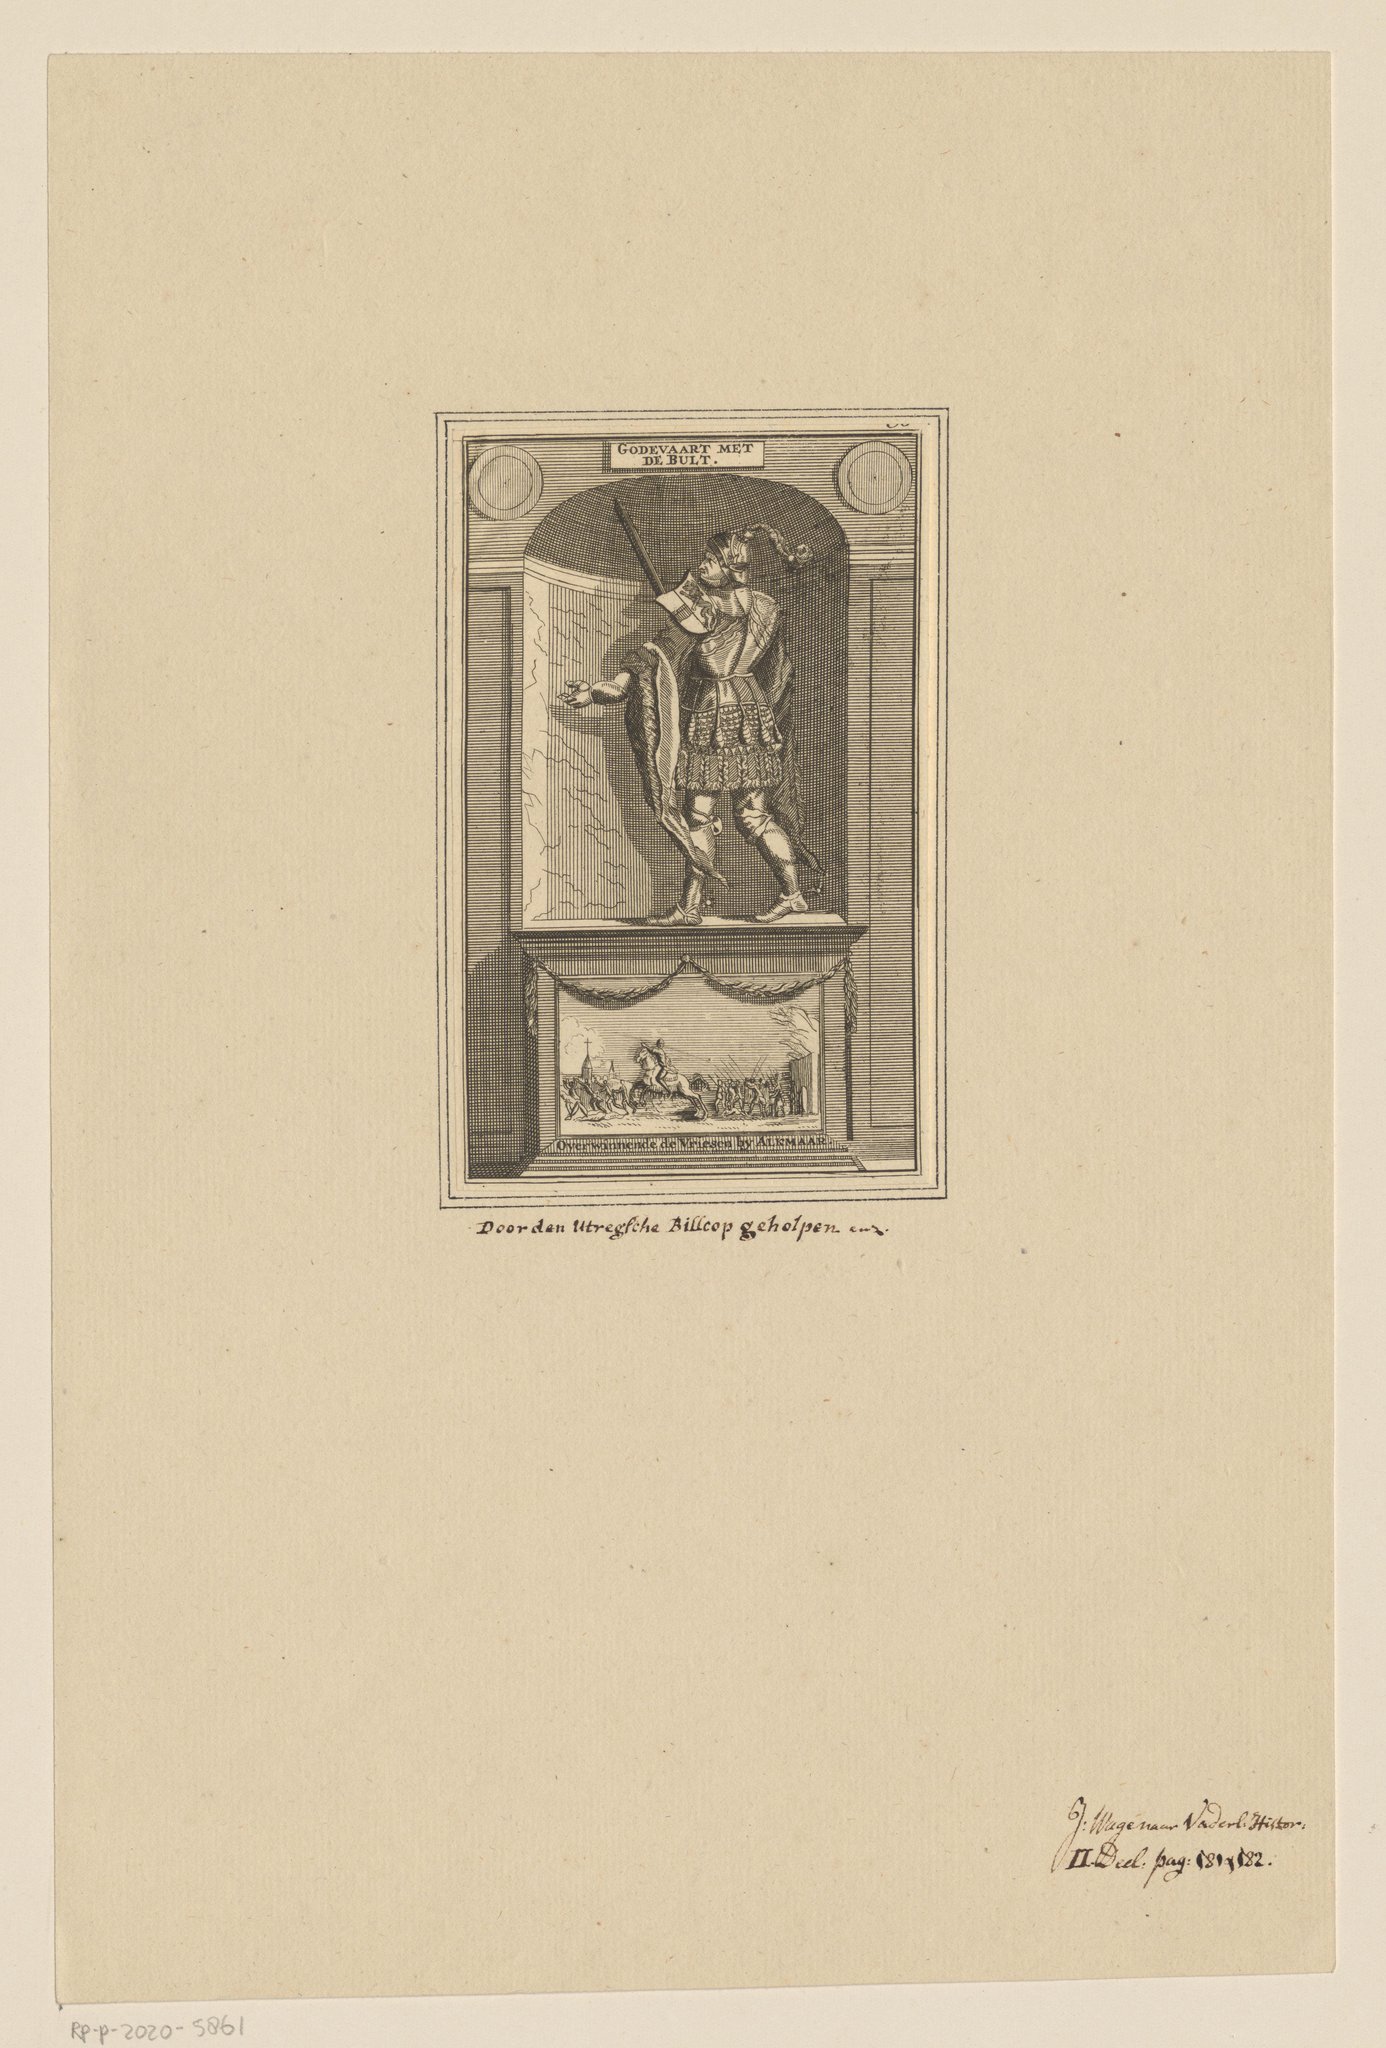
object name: print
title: Portret van Godfried van Lotharingen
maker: Anonymous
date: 1745-1800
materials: paper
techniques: etching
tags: commander-in-chief, general, marshal, historical persons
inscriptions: : ‘Doorden Utregtsche Bisscop geholpen enz./ Jan Wagenaar Vaderl. Histor/ II Deel. Pag 181-182’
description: Tekst in het Nederlands onder het reliëf op de sokkel.